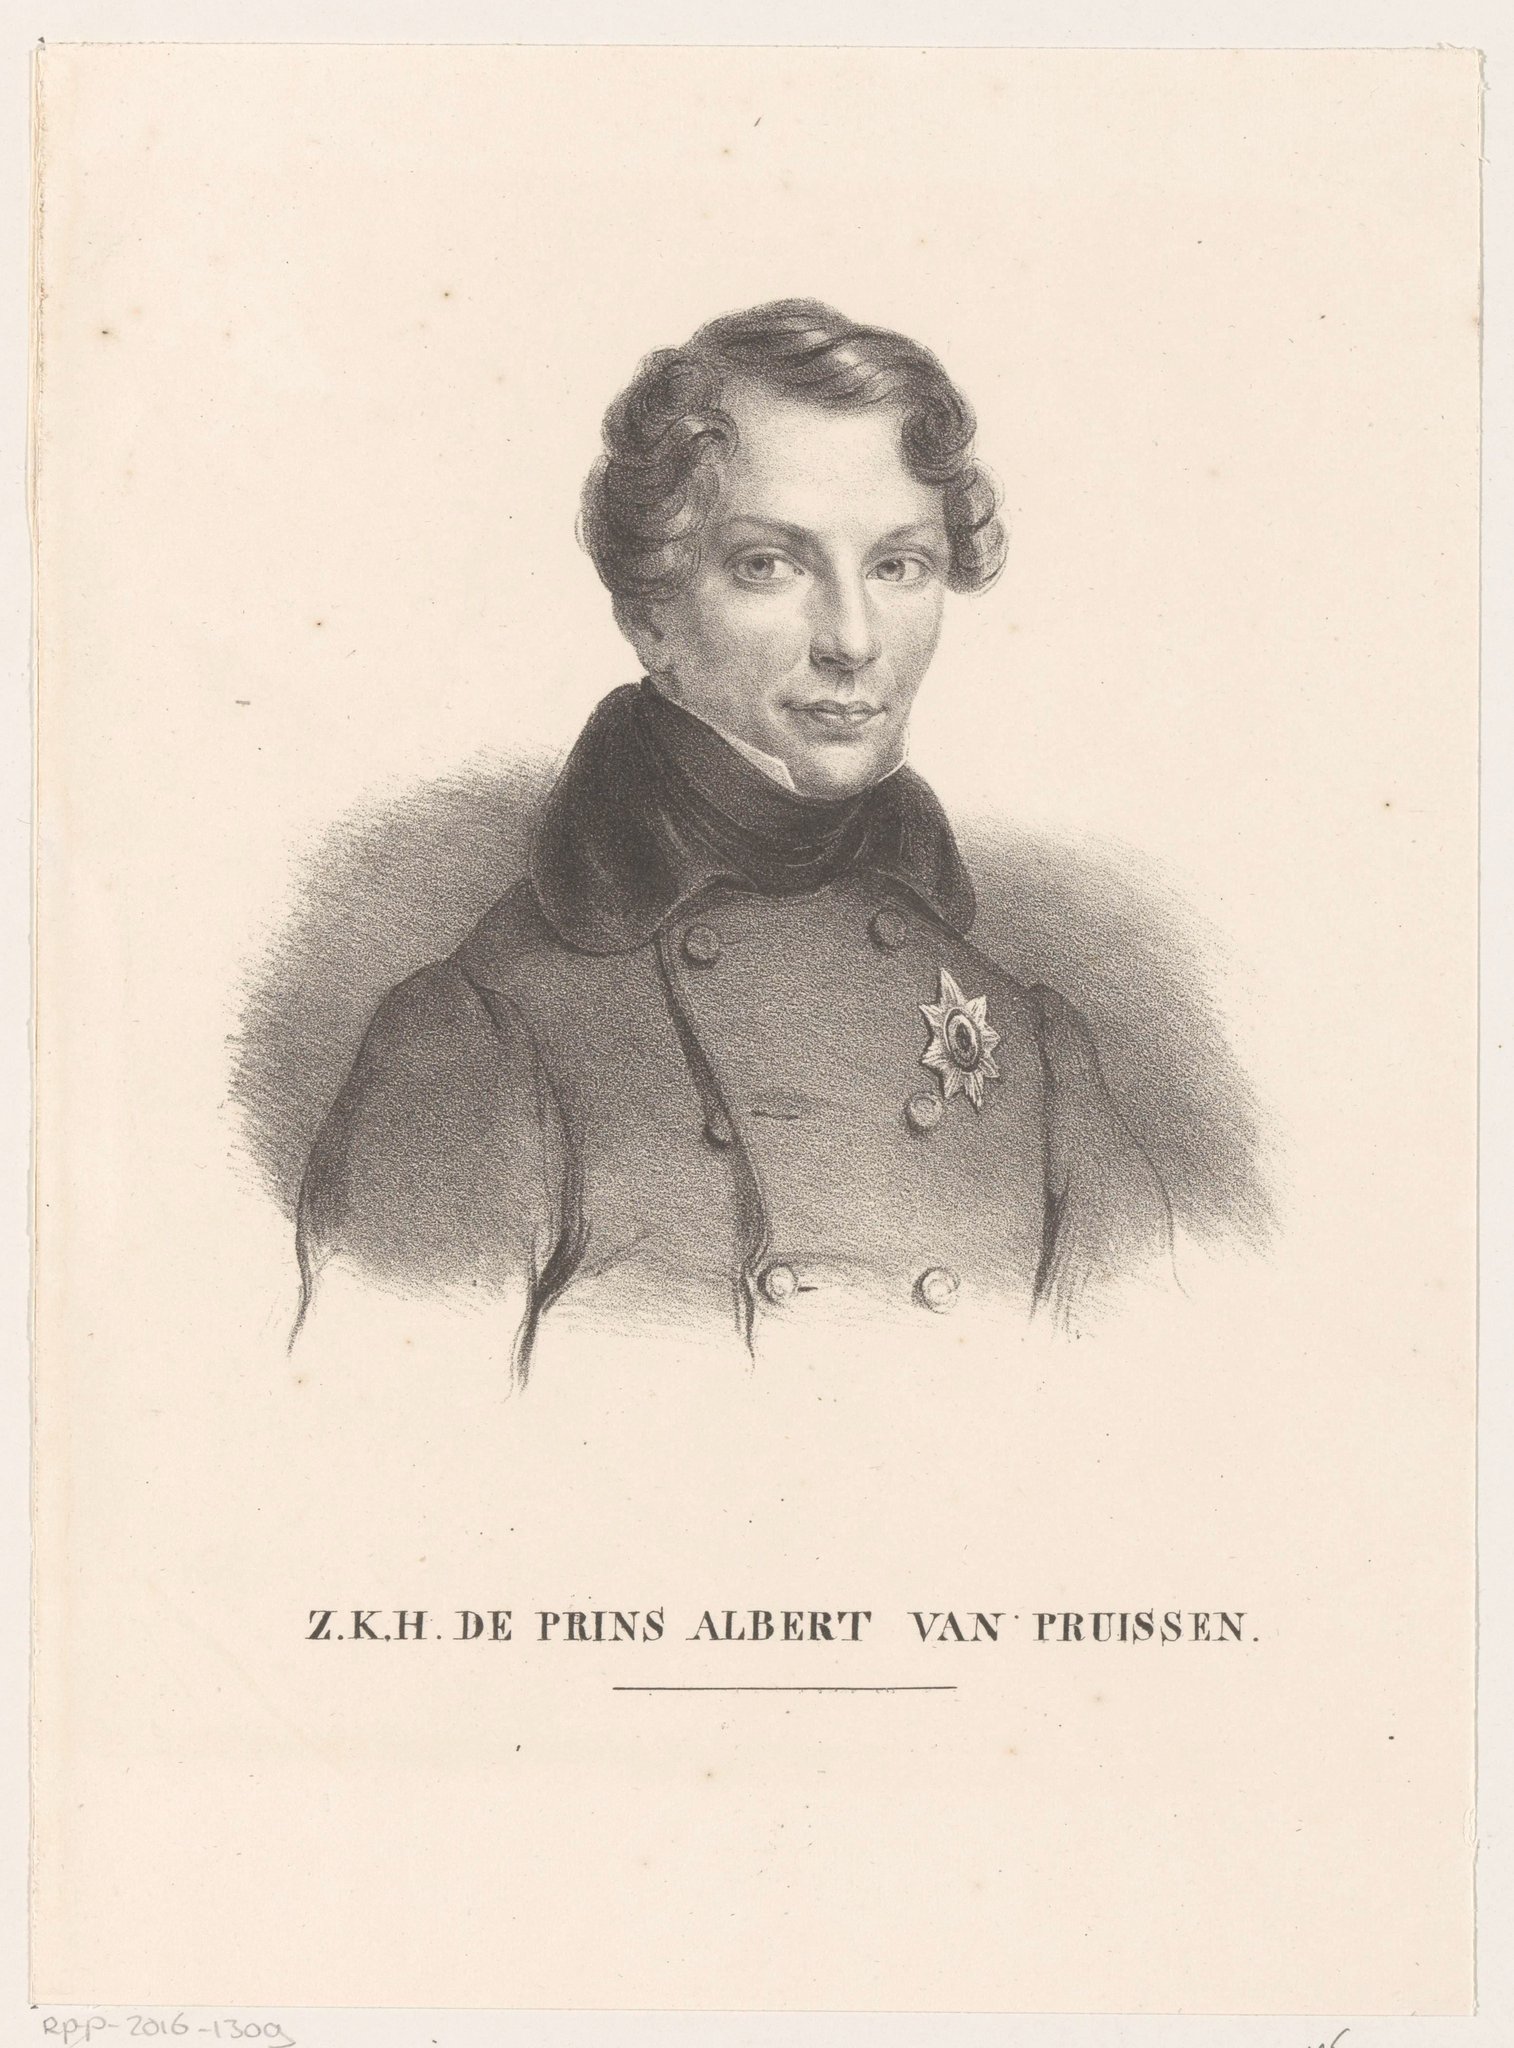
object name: print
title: Portret van Albert Friedrich Heinrich, prins van Pruisen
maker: Anonymous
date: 1825-1899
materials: paper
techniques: lithograph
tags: berlin